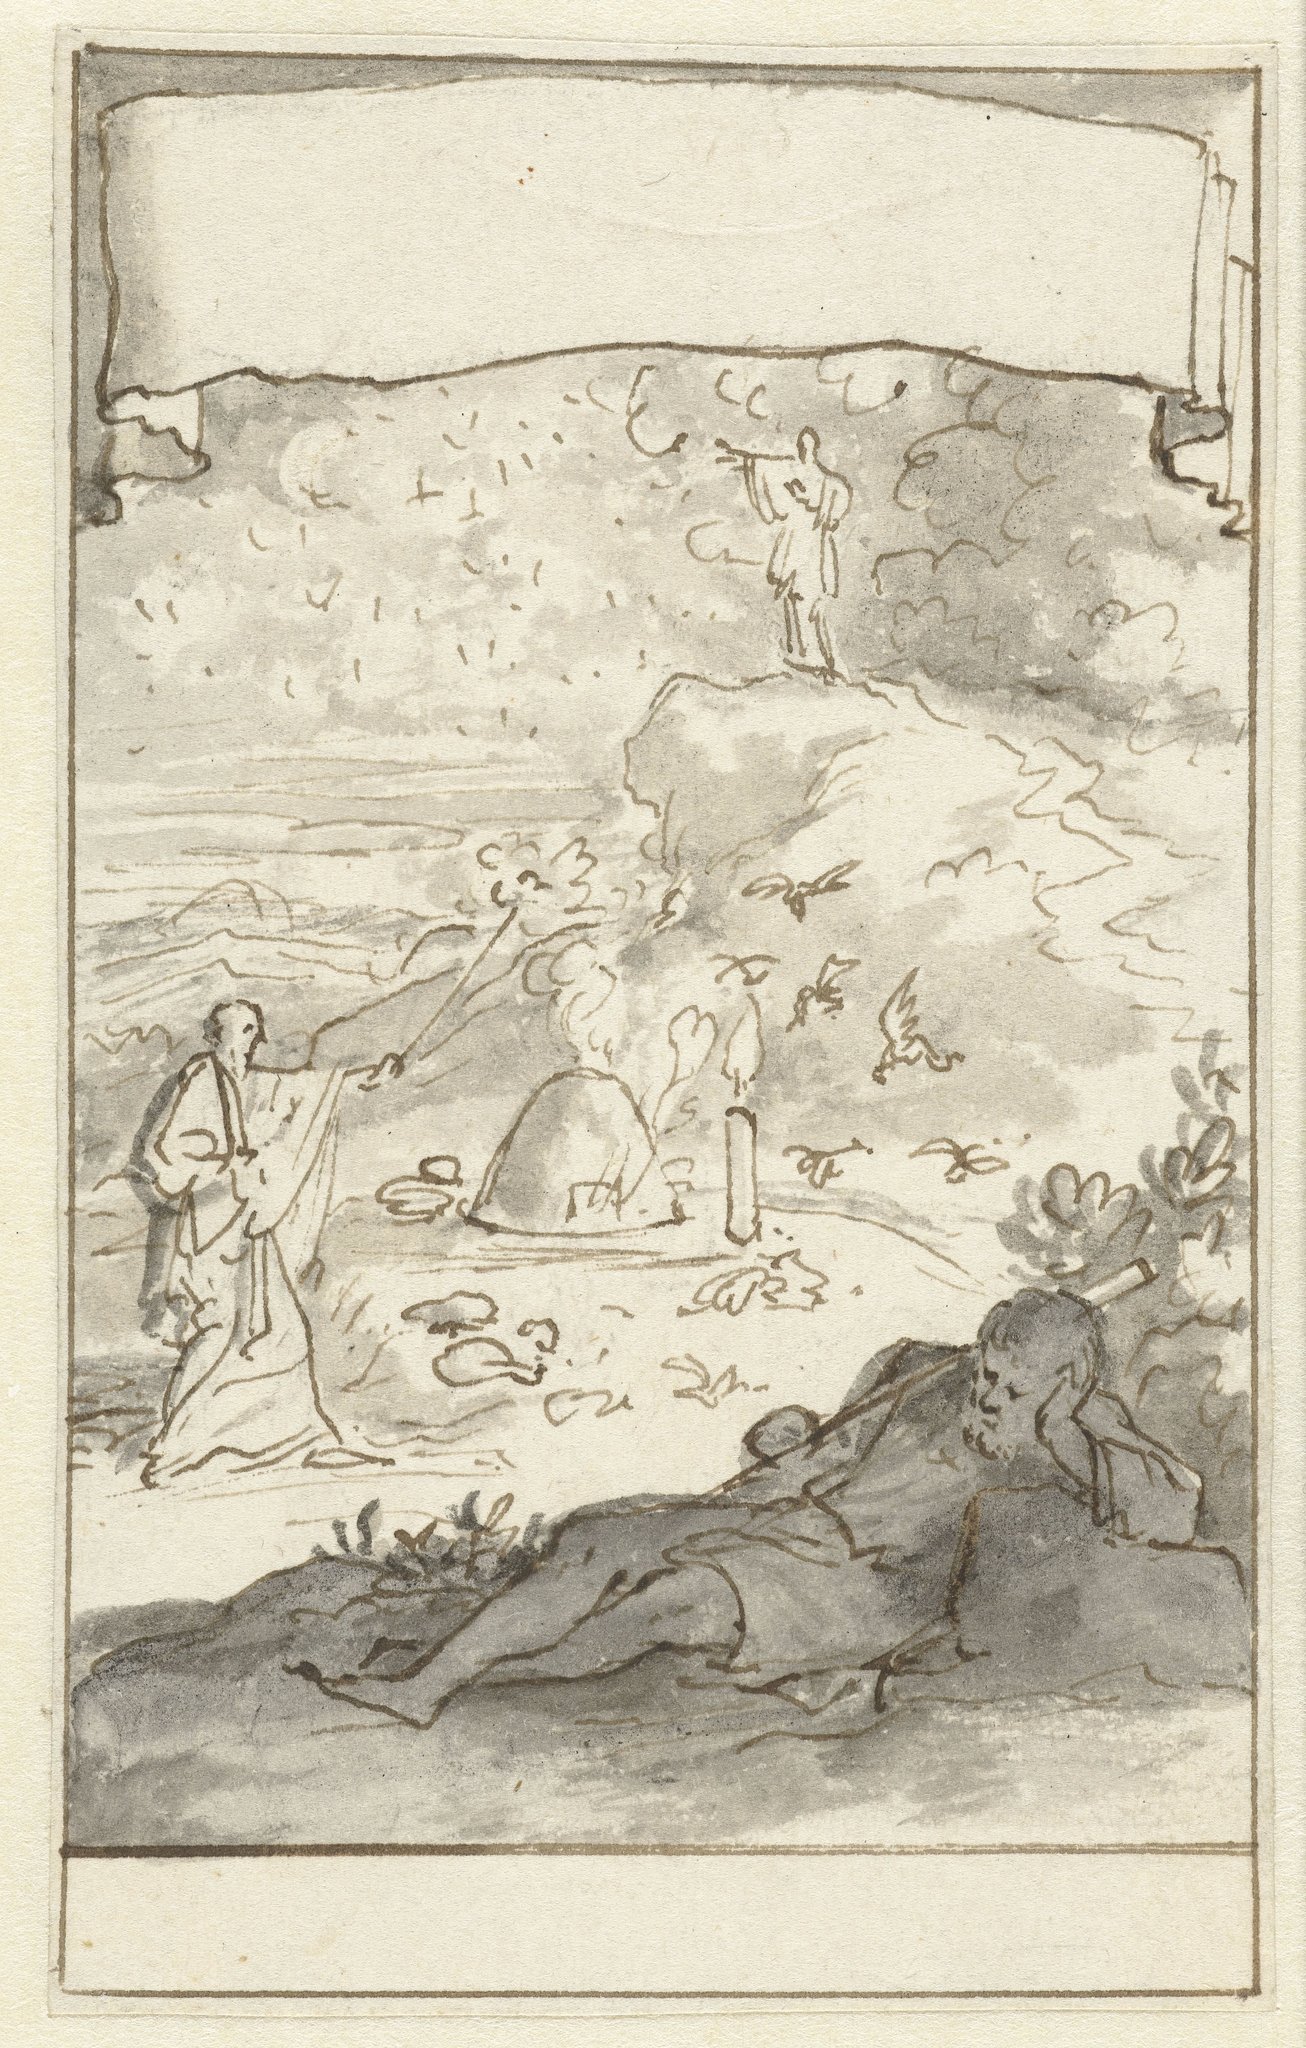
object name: design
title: Ontwerp voor een titelblad met drie scènes uit het leven van Abraham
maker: caspar luyken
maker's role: draughtsman, print maker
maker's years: 1672-1708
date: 1694-1696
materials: ink, paper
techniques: brush, pen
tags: abraham counting the stars, abraham chases away the birds that come down on the carcasses, abraham falls asleep ~ sacrifice, the vision of the smoking furnace and the burning lamp in the night ~ abraham's sacrifice